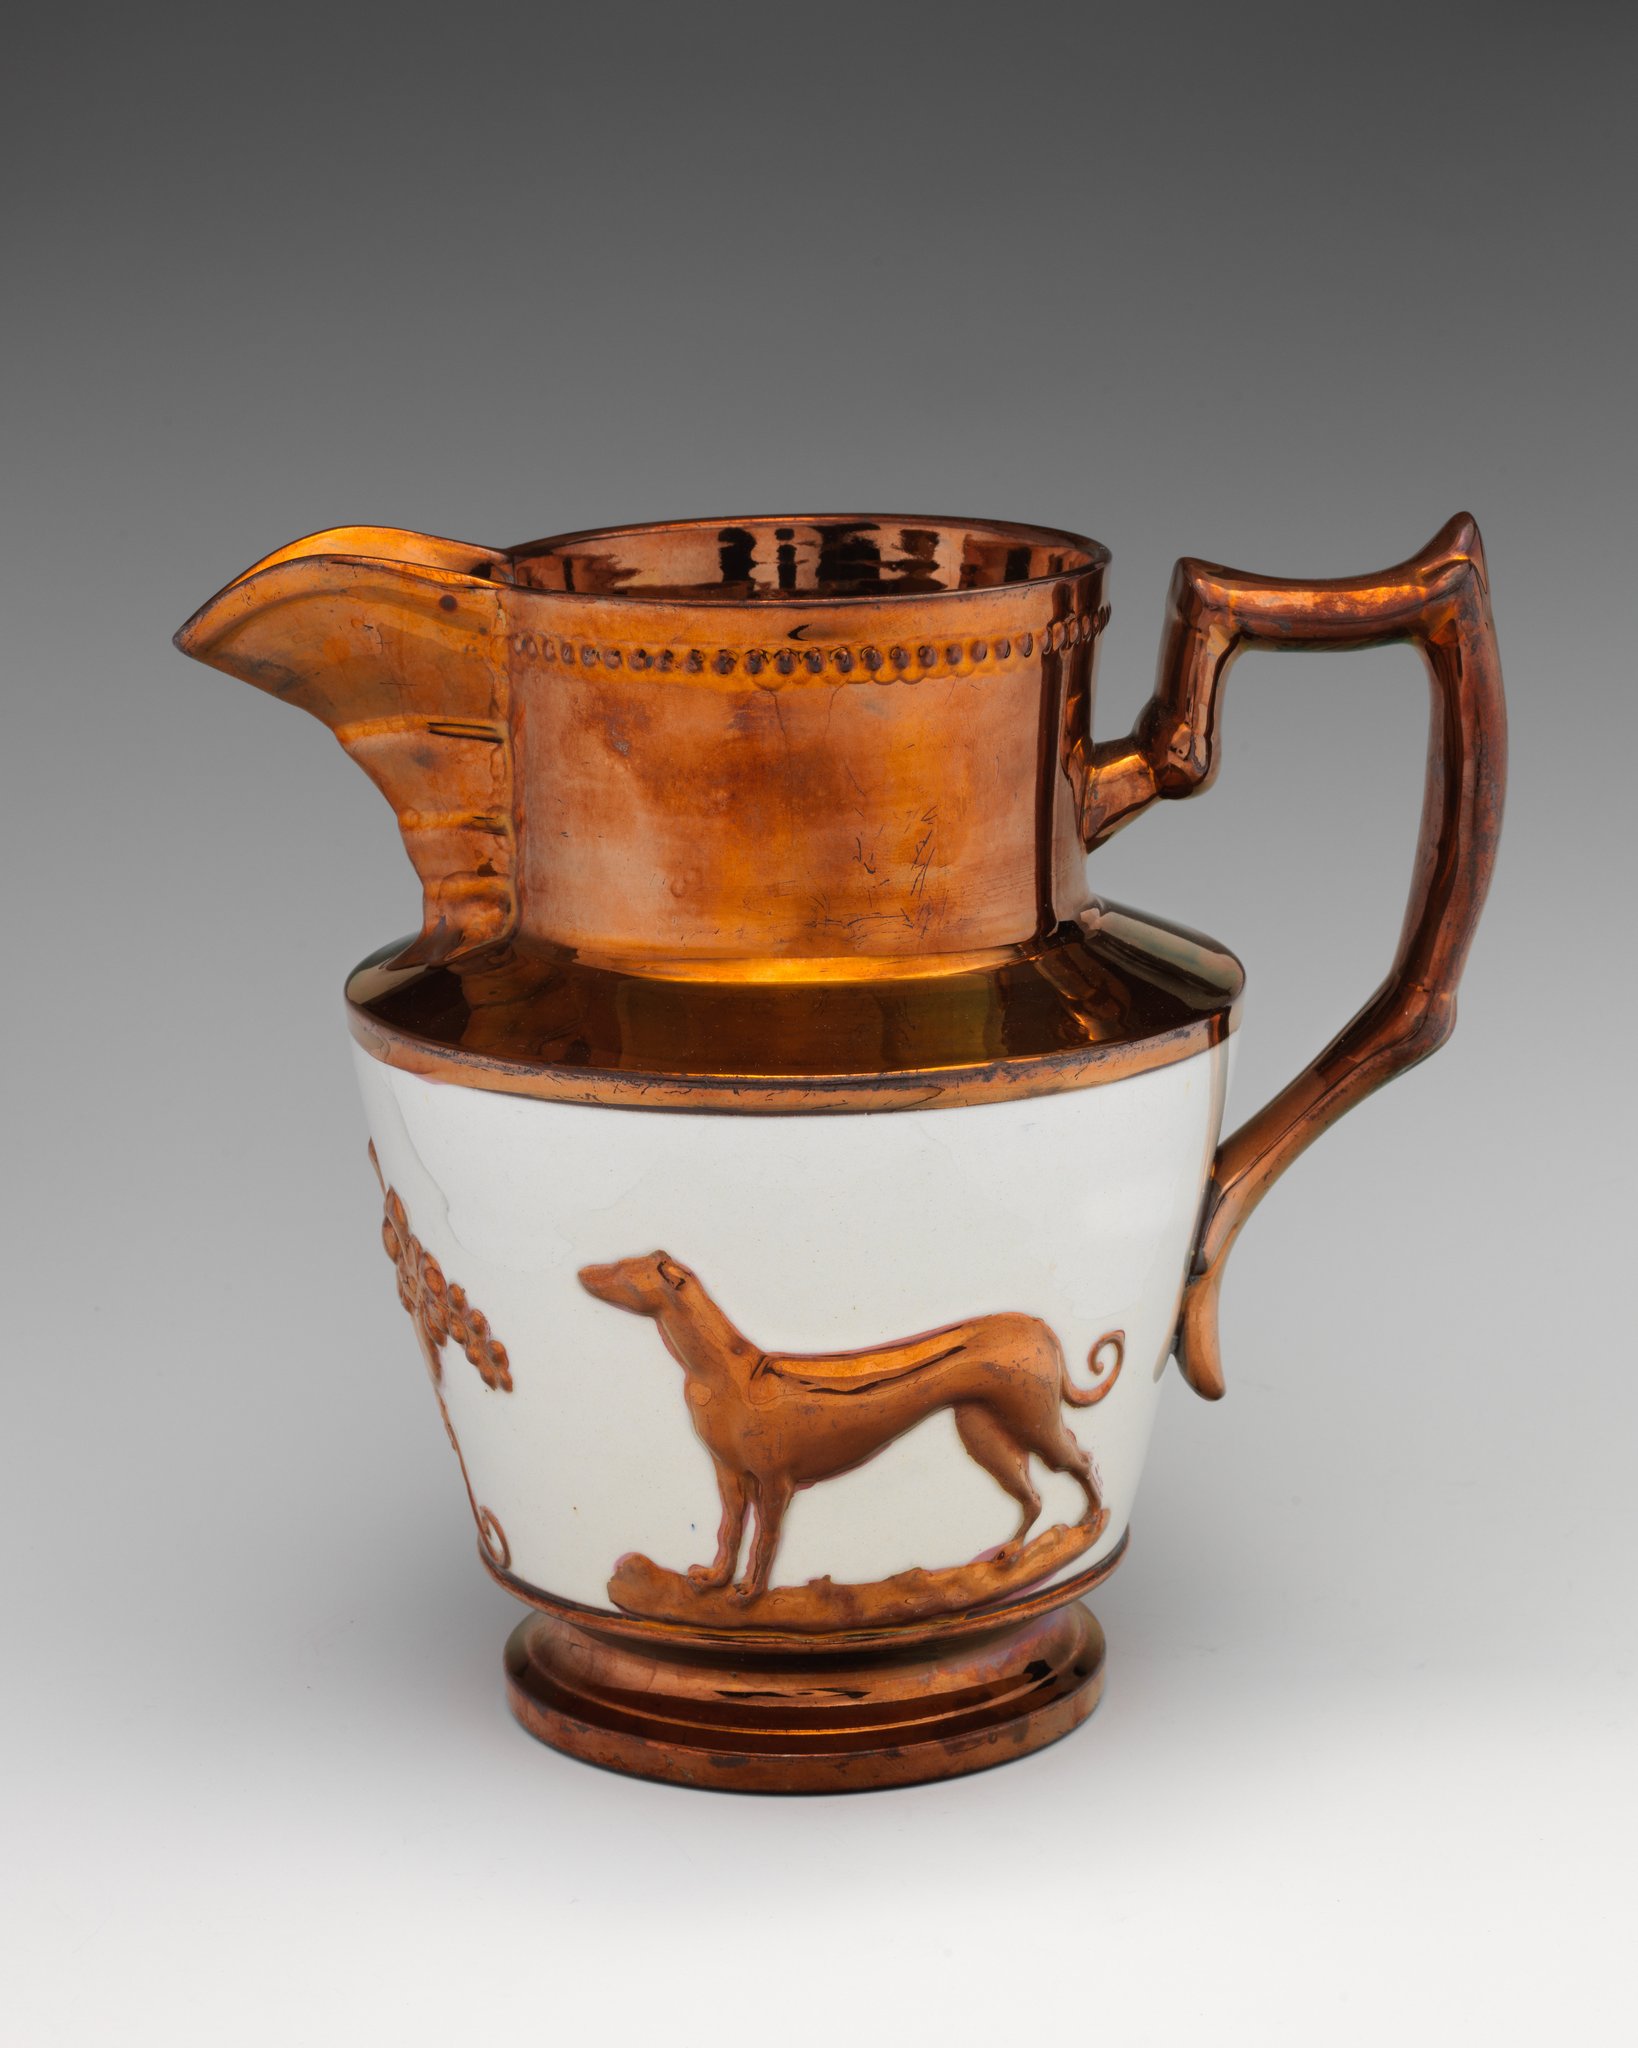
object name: jug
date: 1801-1900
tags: dogs